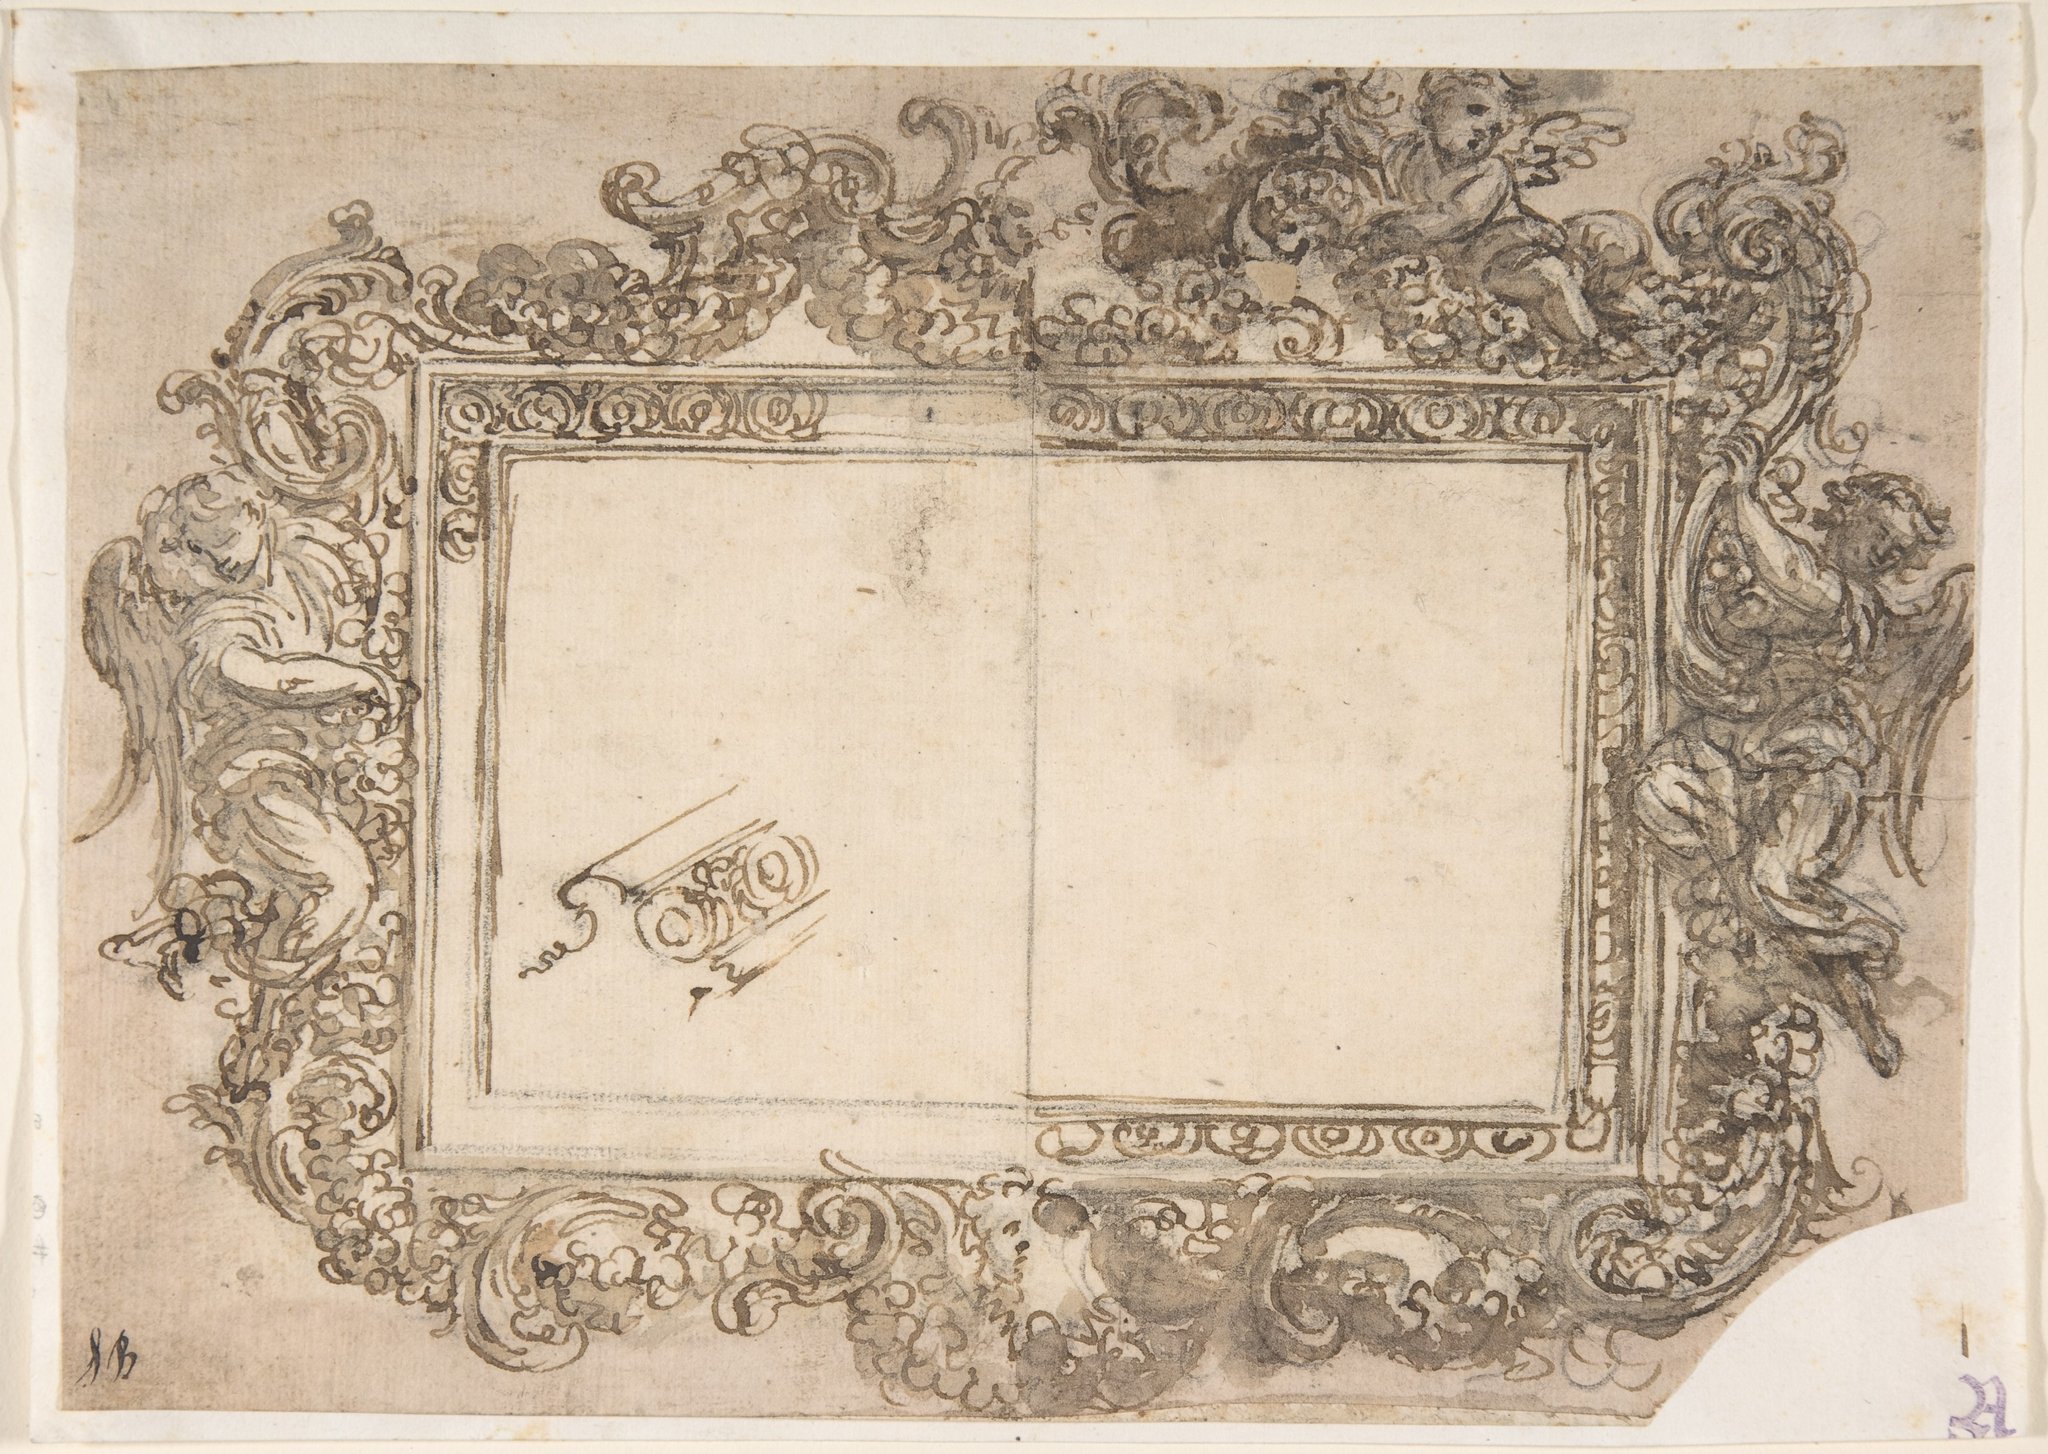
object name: drawing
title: Design for a Carved or Openworked Frame with a Variant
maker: giovanni battista foggini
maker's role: artist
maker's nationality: italian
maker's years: 1652-1725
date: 1672-1725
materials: chalk, graphite, ink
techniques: brush, pen, wash